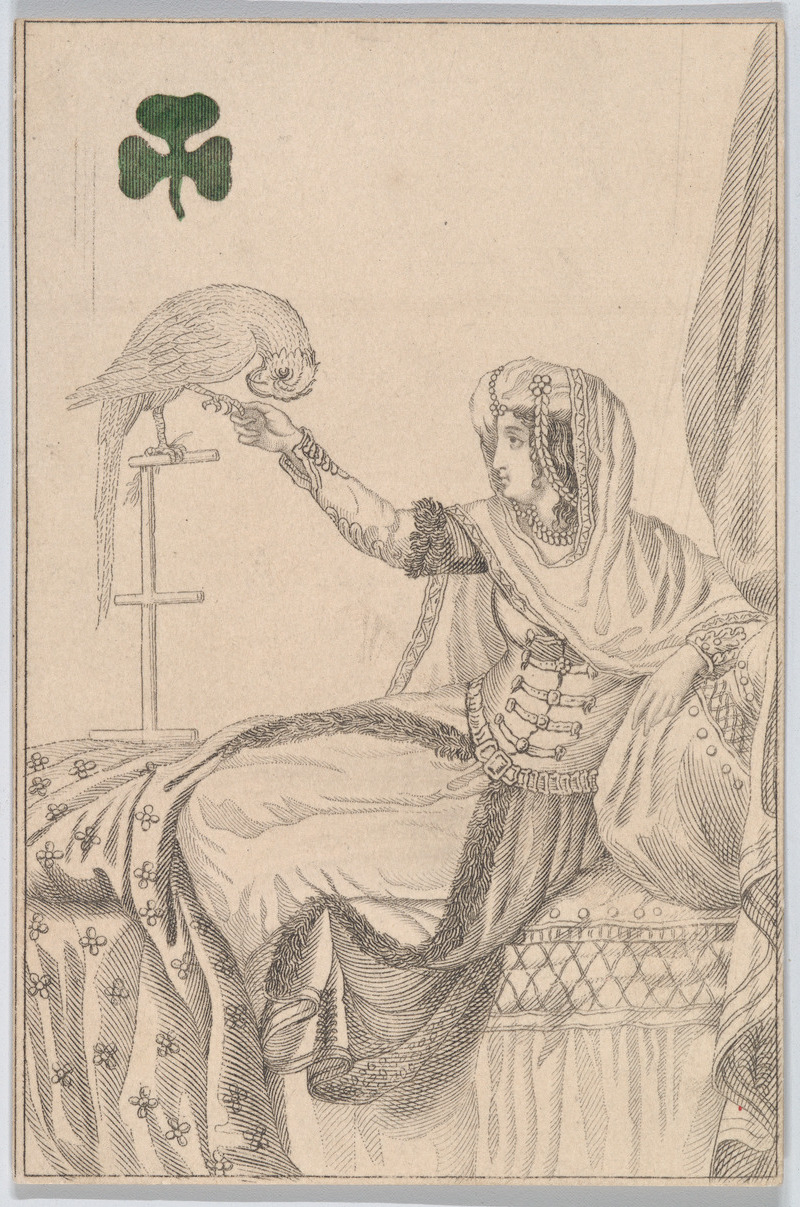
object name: print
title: Queen (Zulemer from Algiers), from "Court Game of Geography"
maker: william and henry rock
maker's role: publisher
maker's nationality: british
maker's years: 1821-1884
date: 1838-1855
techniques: engraving, etching, hand coloring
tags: birds,queens,playing cards